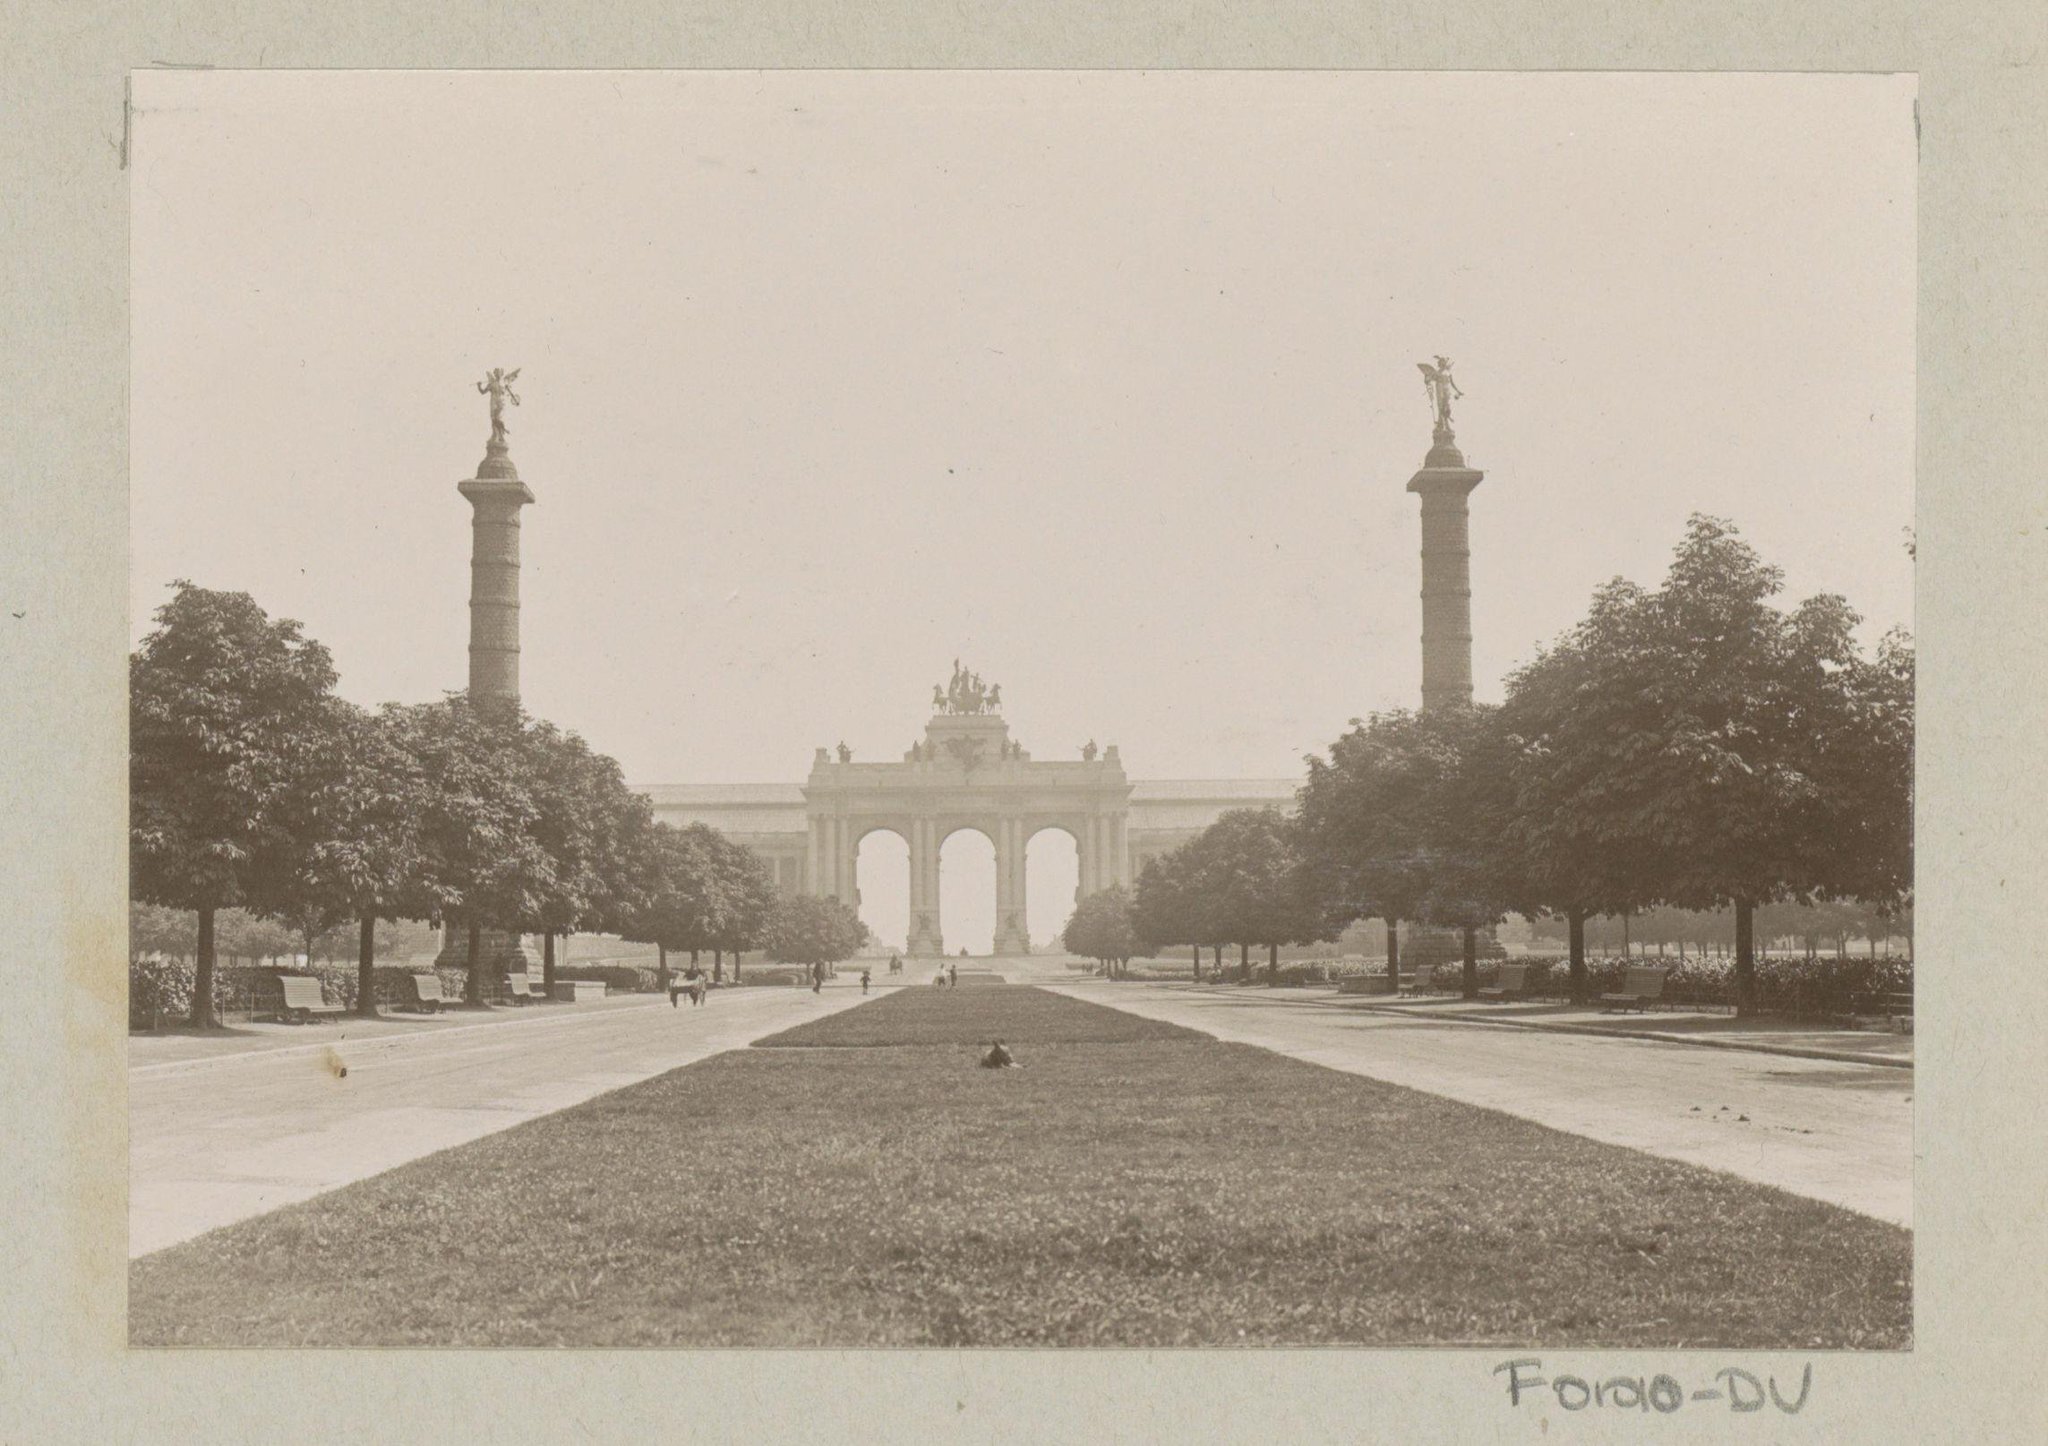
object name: photograph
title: Zuilen en triomfboog in het Jubelpark te Brussel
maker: Anonymous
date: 1900-1910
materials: photographic support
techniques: matte daylight collodion silver print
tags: public gardens, park (+ city(-scape) with figures, staffage), triumphal arch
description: Onderdeel van Familiealbum met onder meer foto's van Wijnhandel Kraaij & Co. Bordeaux-Amsterdam.